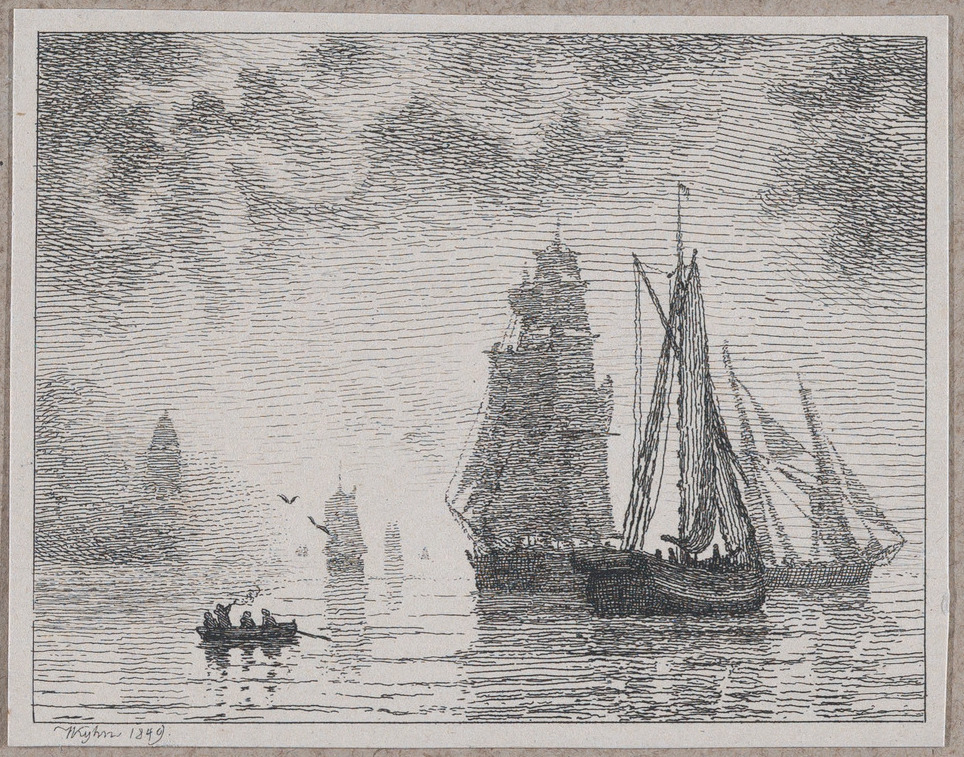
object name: print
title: Maritime and Rural Views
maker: peter vilhelm carl kyhn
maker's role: artist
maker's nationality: danish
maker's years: 1819-1903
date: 1847-1853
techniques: etching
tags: boats,ships